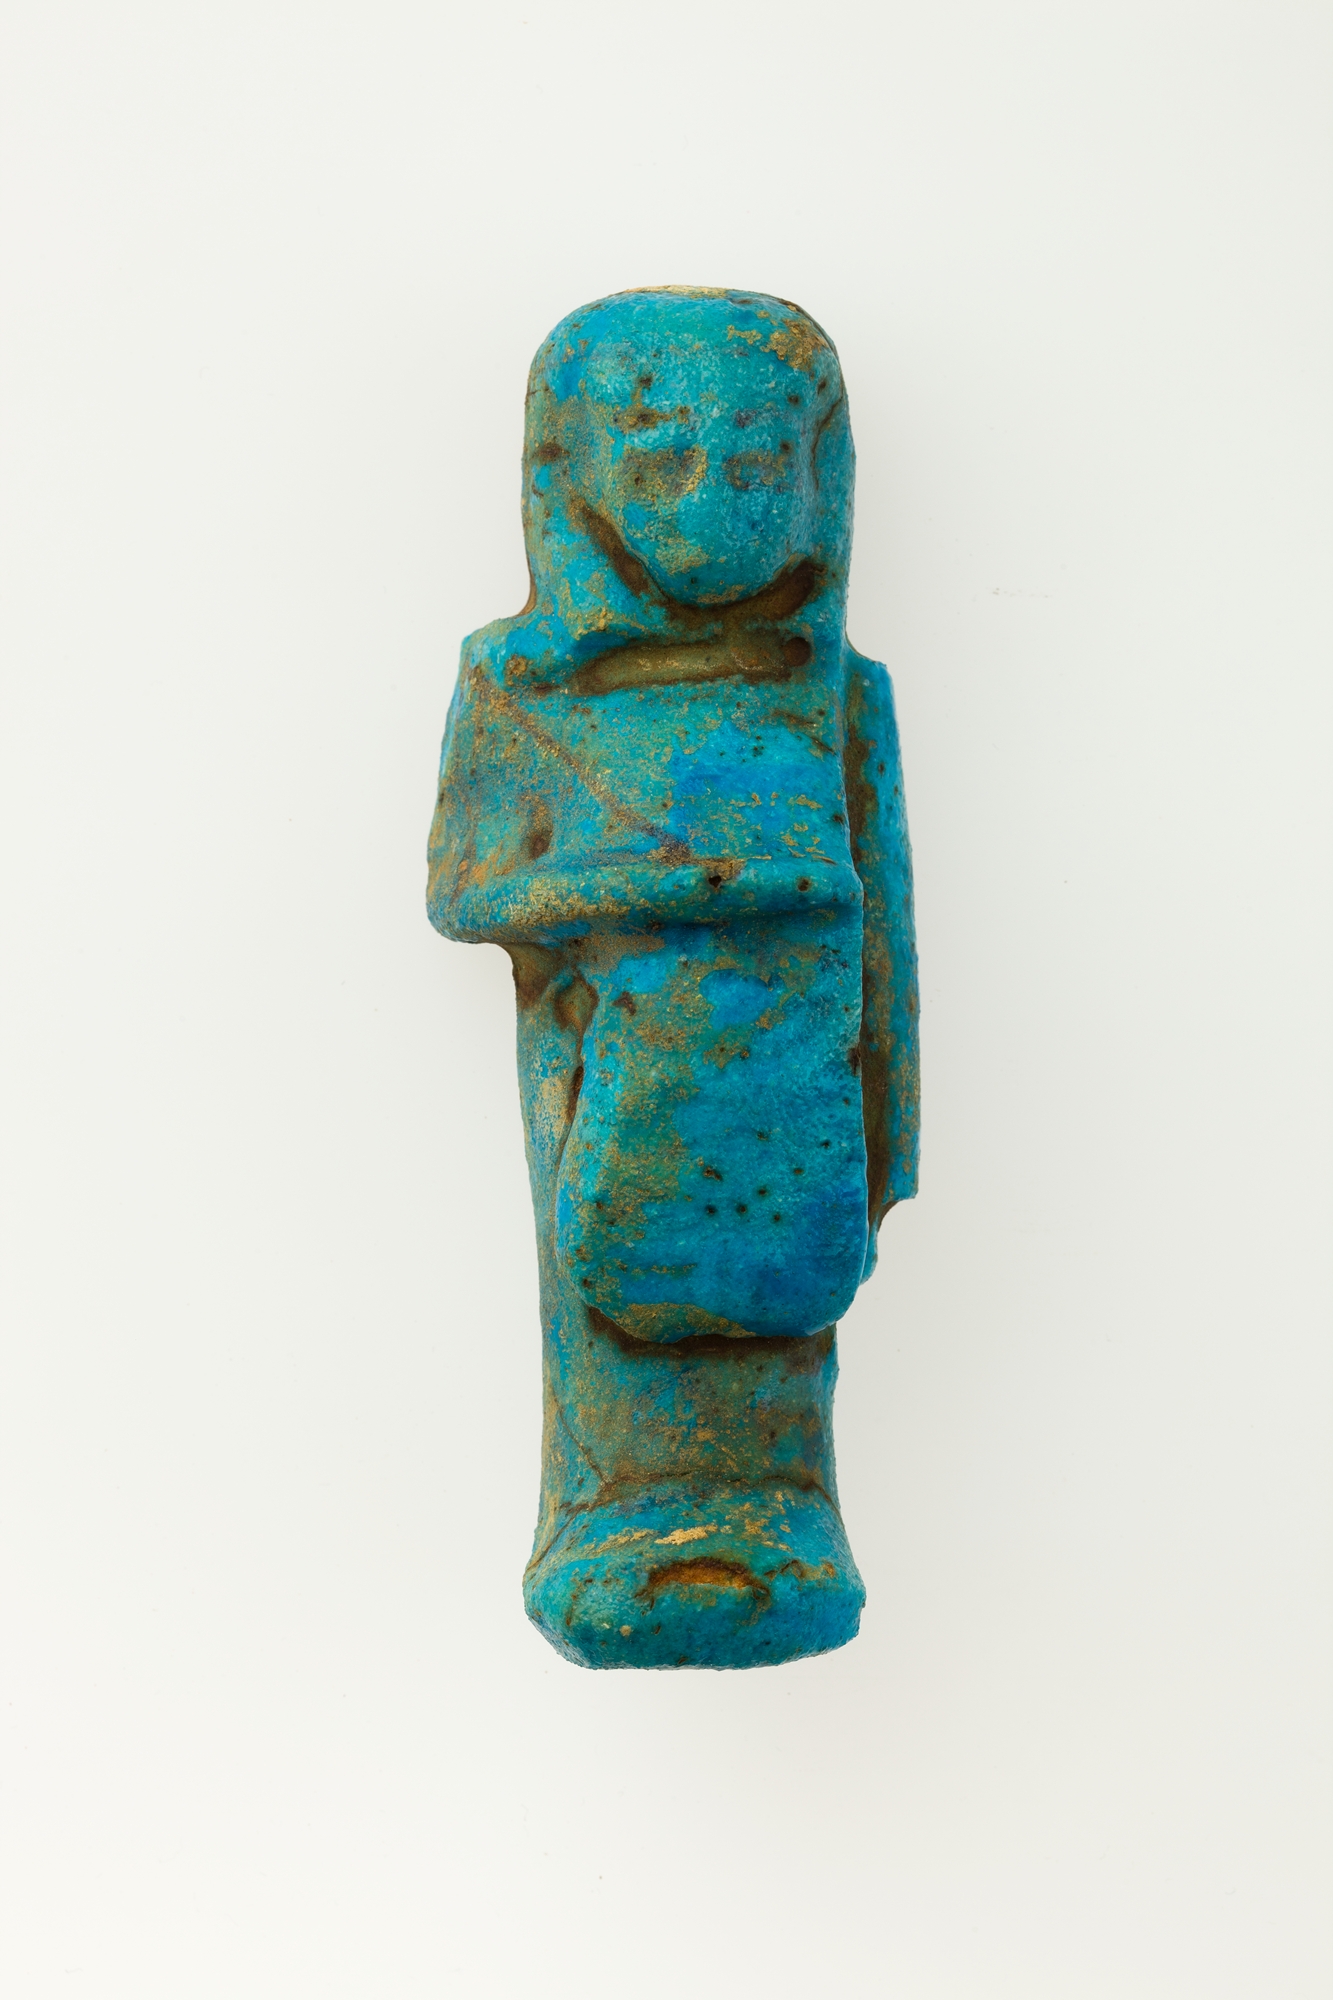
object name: shabti, henettawy c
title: Overseer Shabti of Henettawy (C), Daughter of Isetemkheb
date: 990-970 BCE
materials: faience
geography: egypt